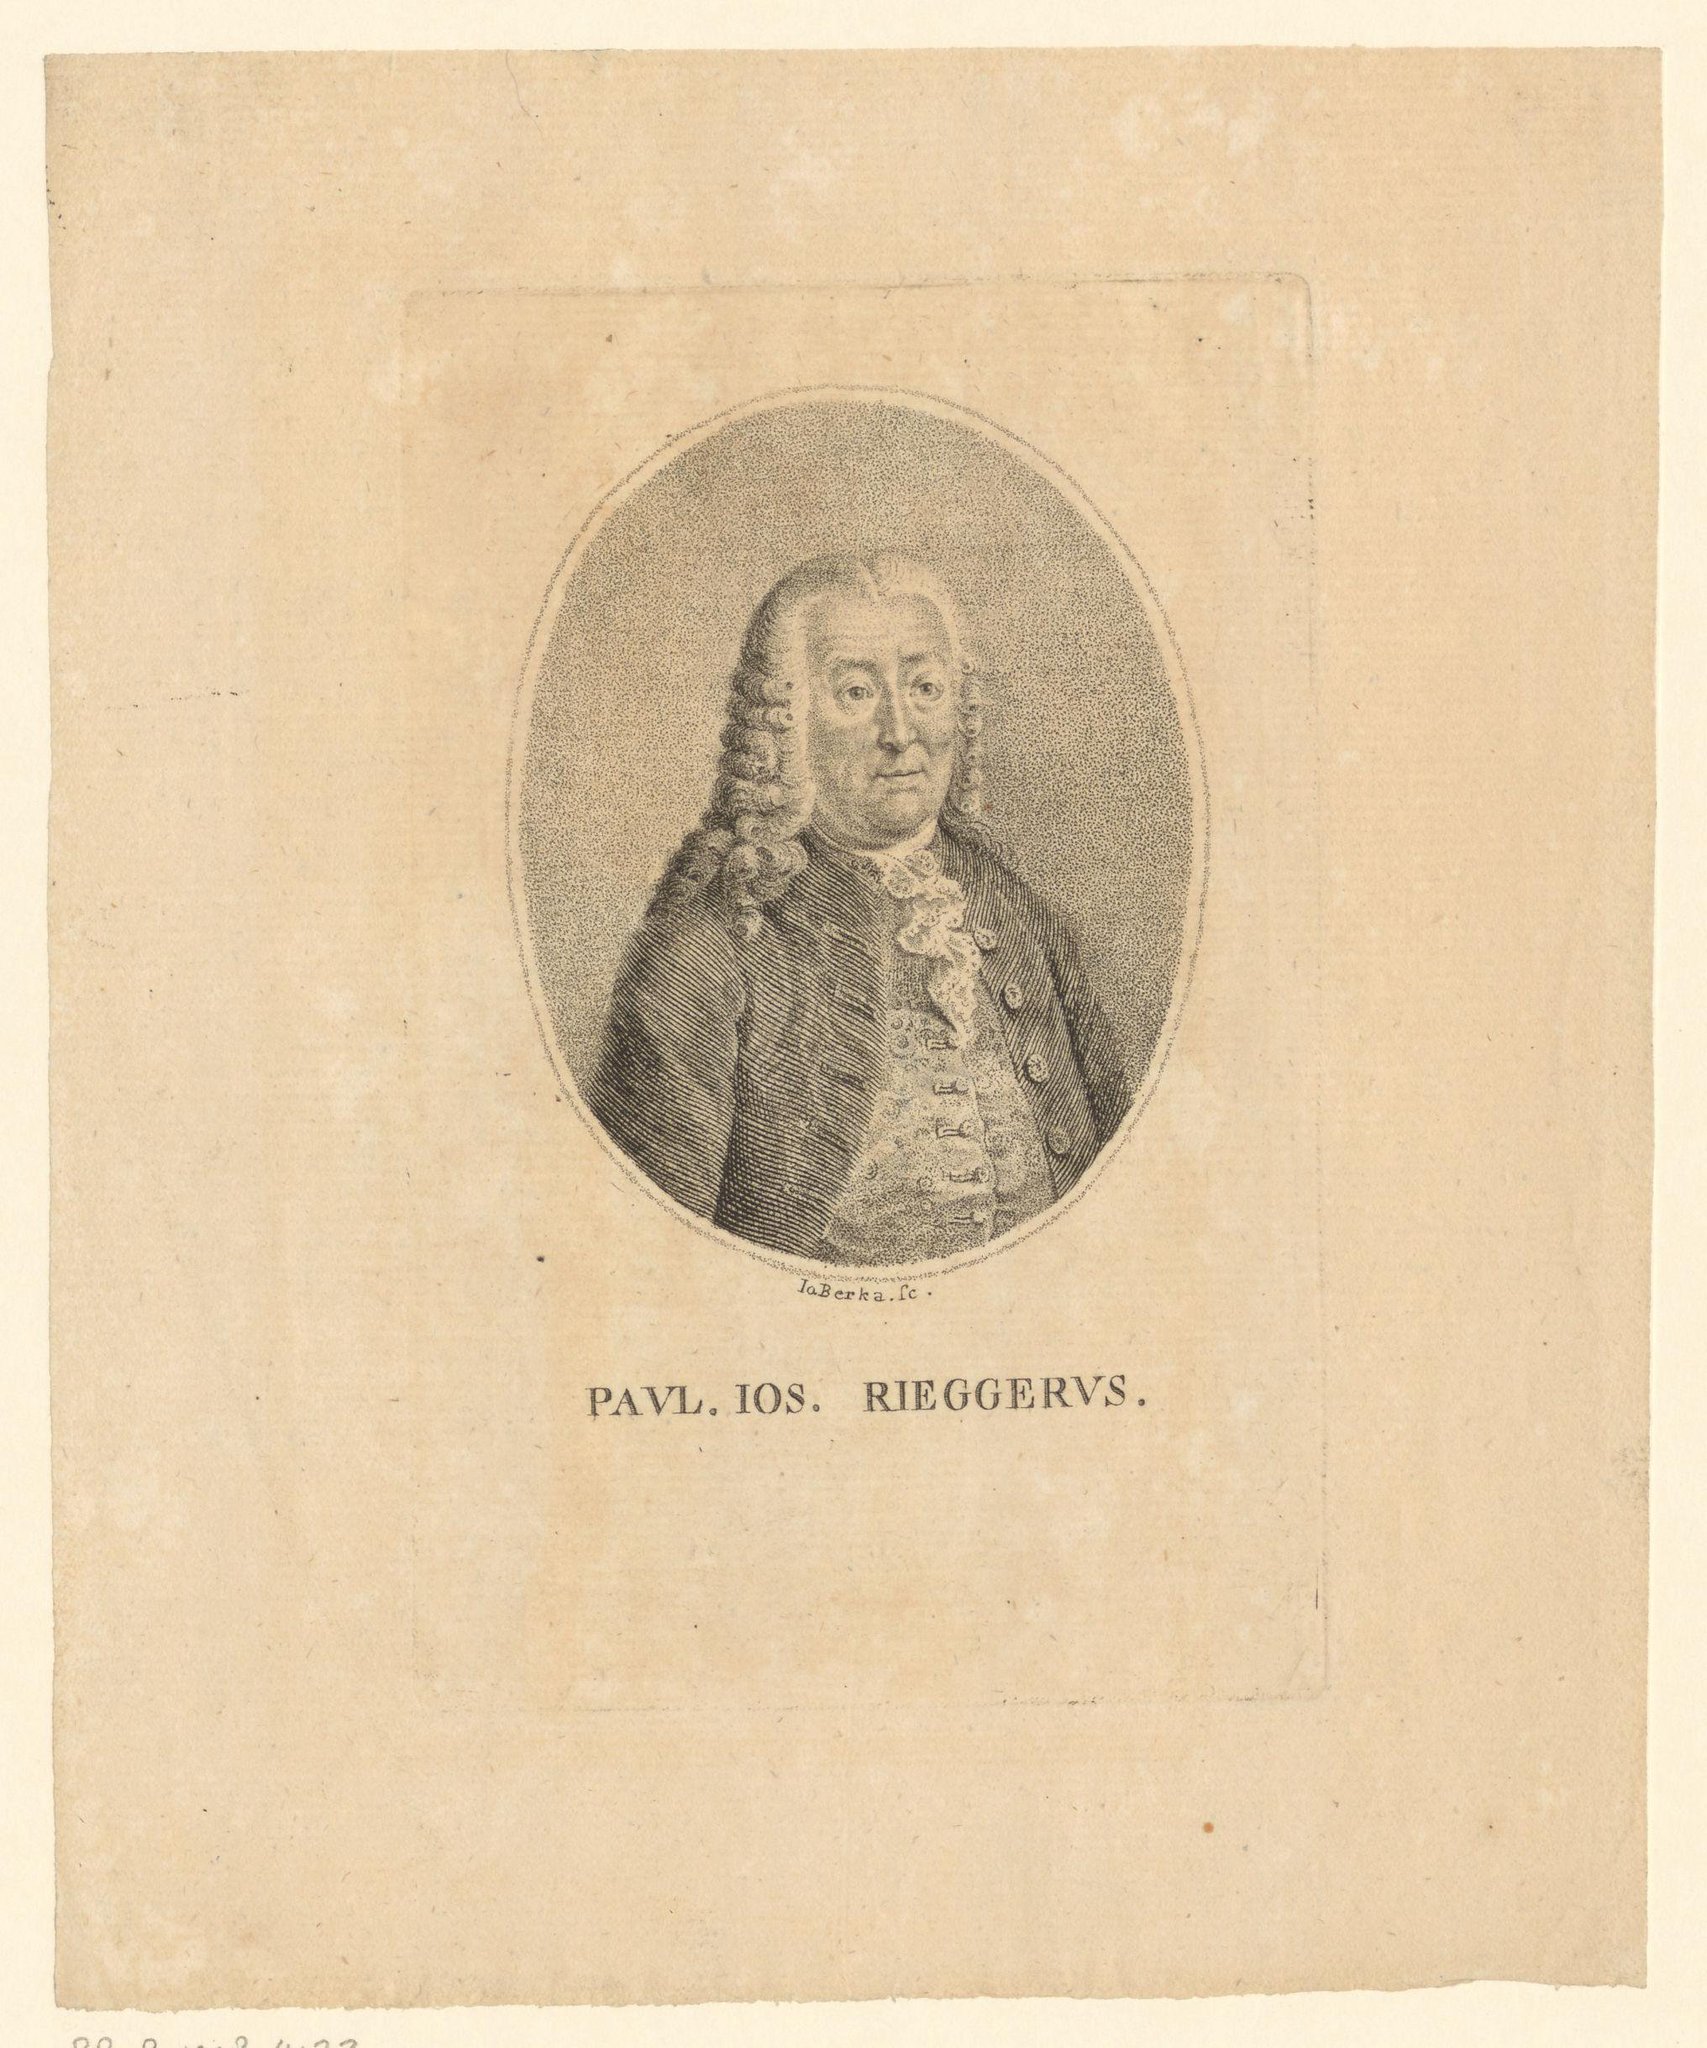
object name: print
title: Portret van Paul Joseph Riegger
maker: johann berka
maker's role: painter, print maker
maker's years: 1759-1838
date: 1769-1838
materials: paper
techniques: etching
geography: prague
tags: vienna, historical persons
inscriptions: collector's mark: Lugt 2228